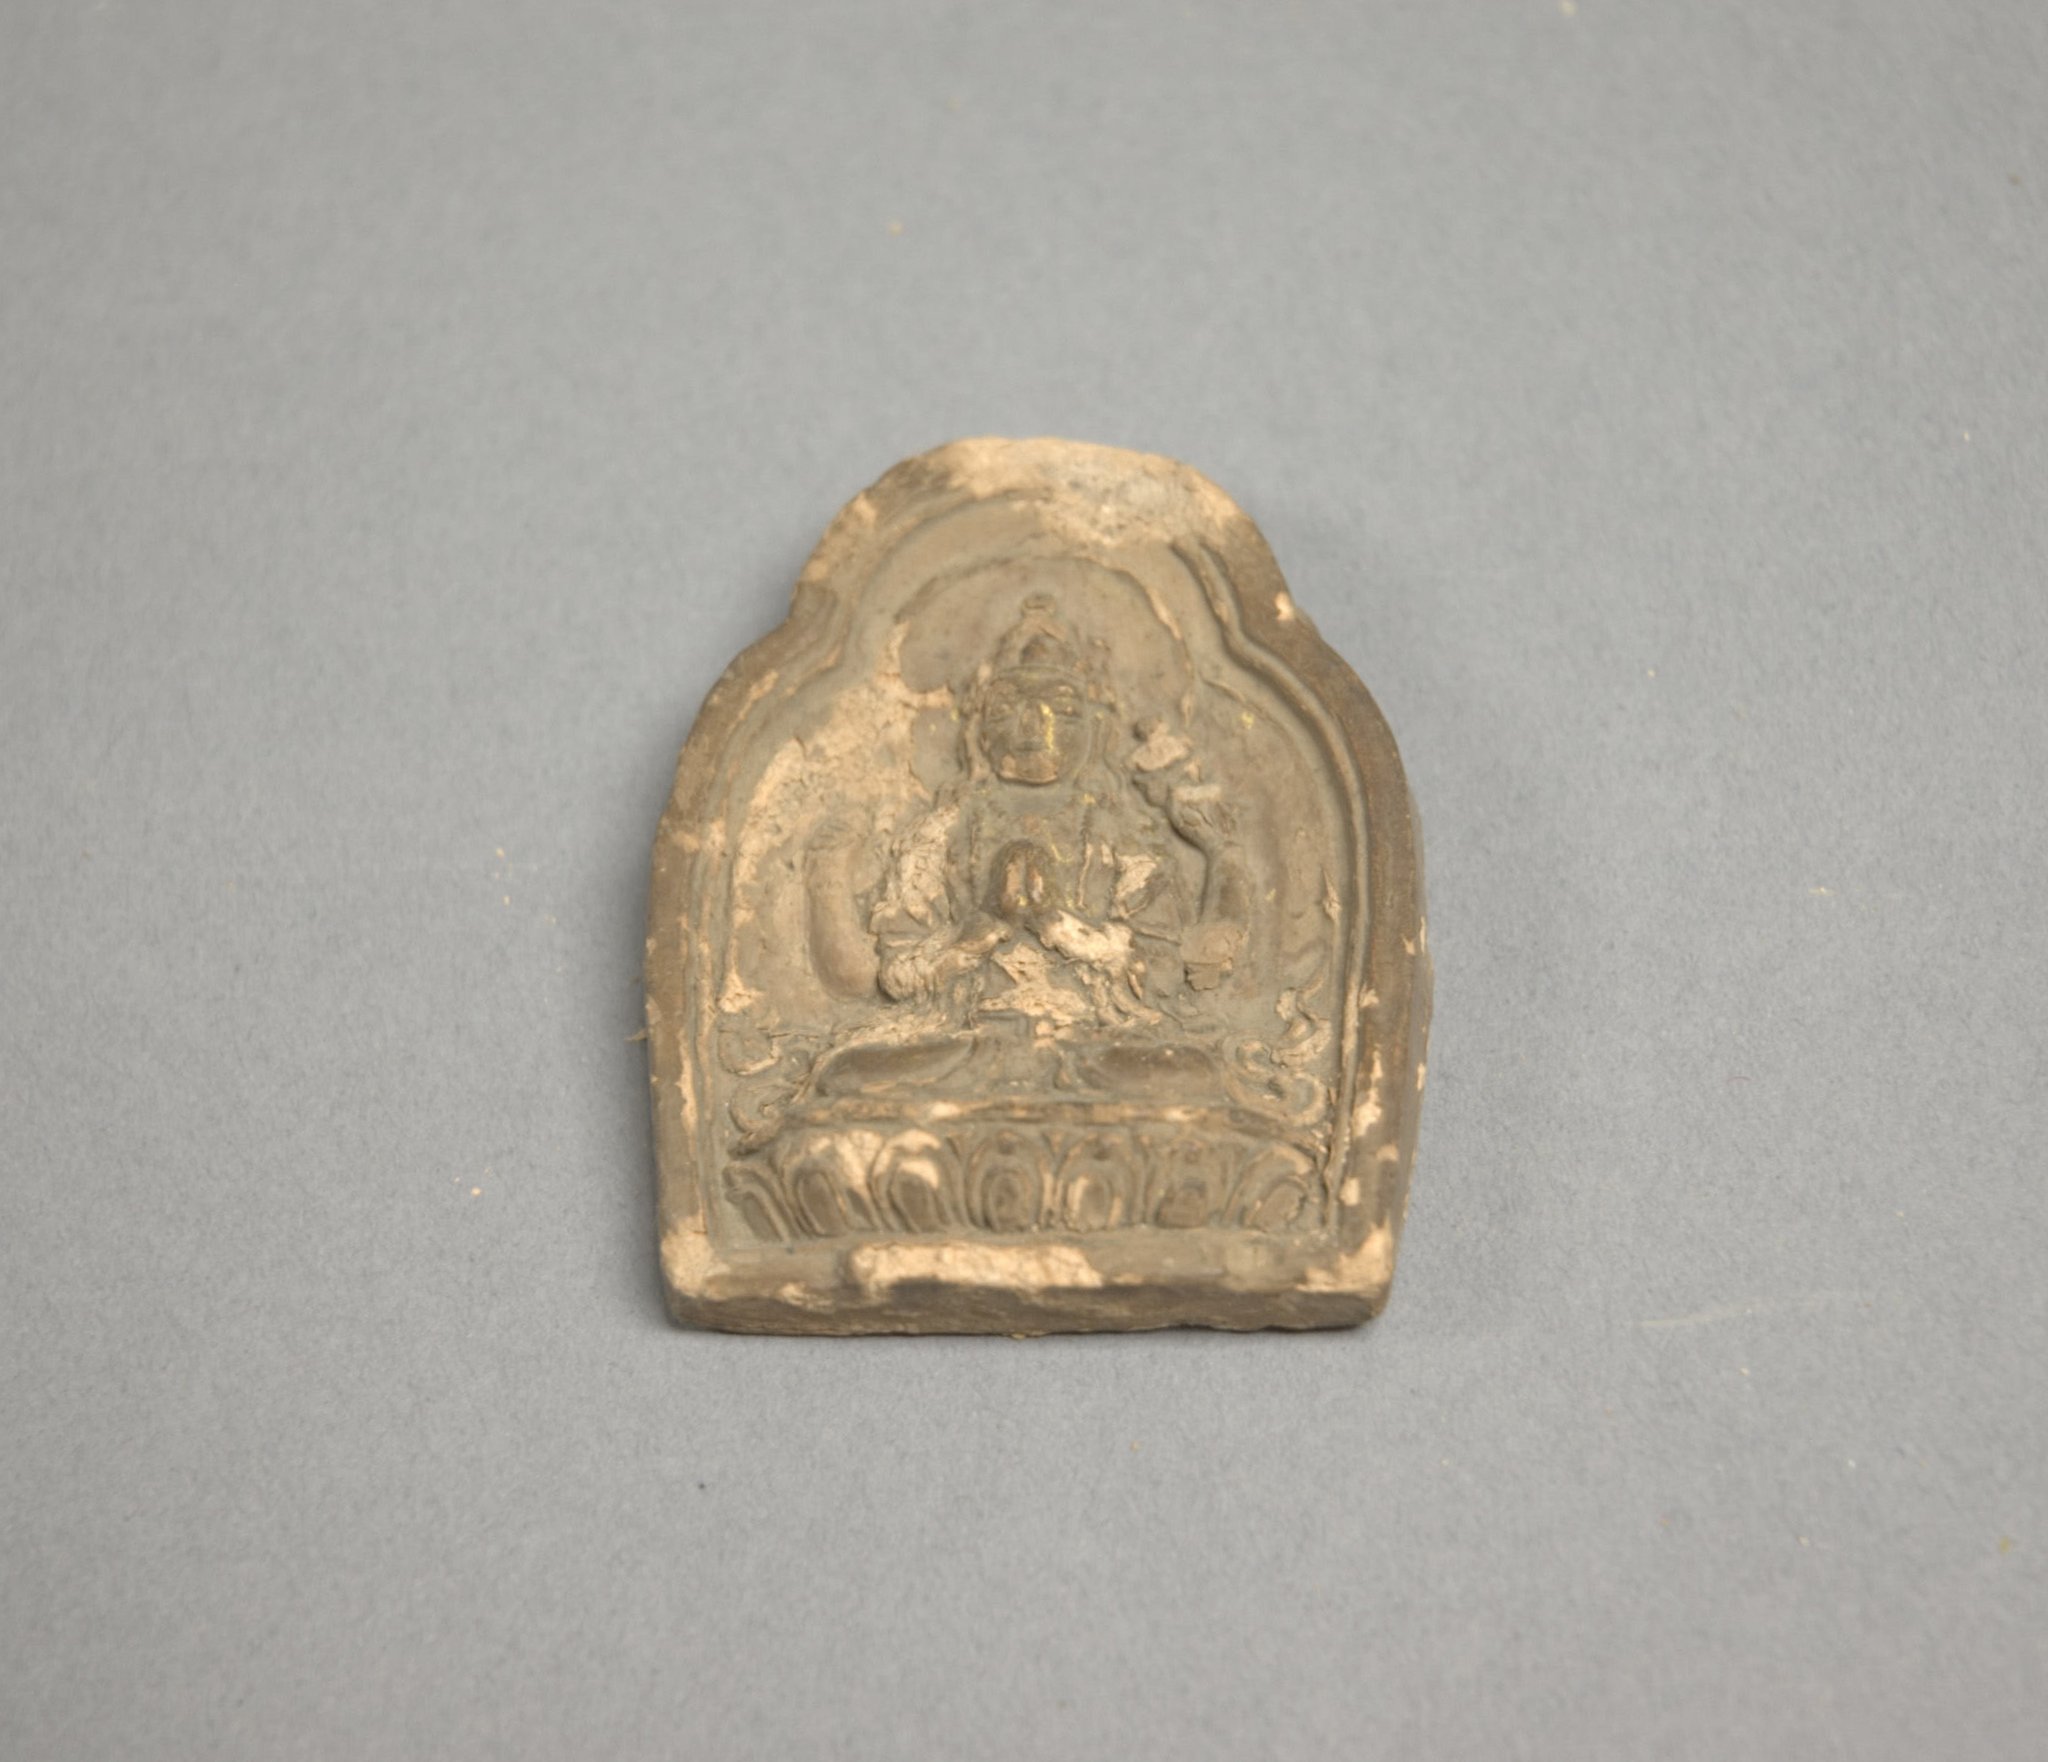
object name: plaque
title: Votive Plaque with Seated Figure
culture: tibetan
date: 1368-1643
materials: pottery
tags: lotuses